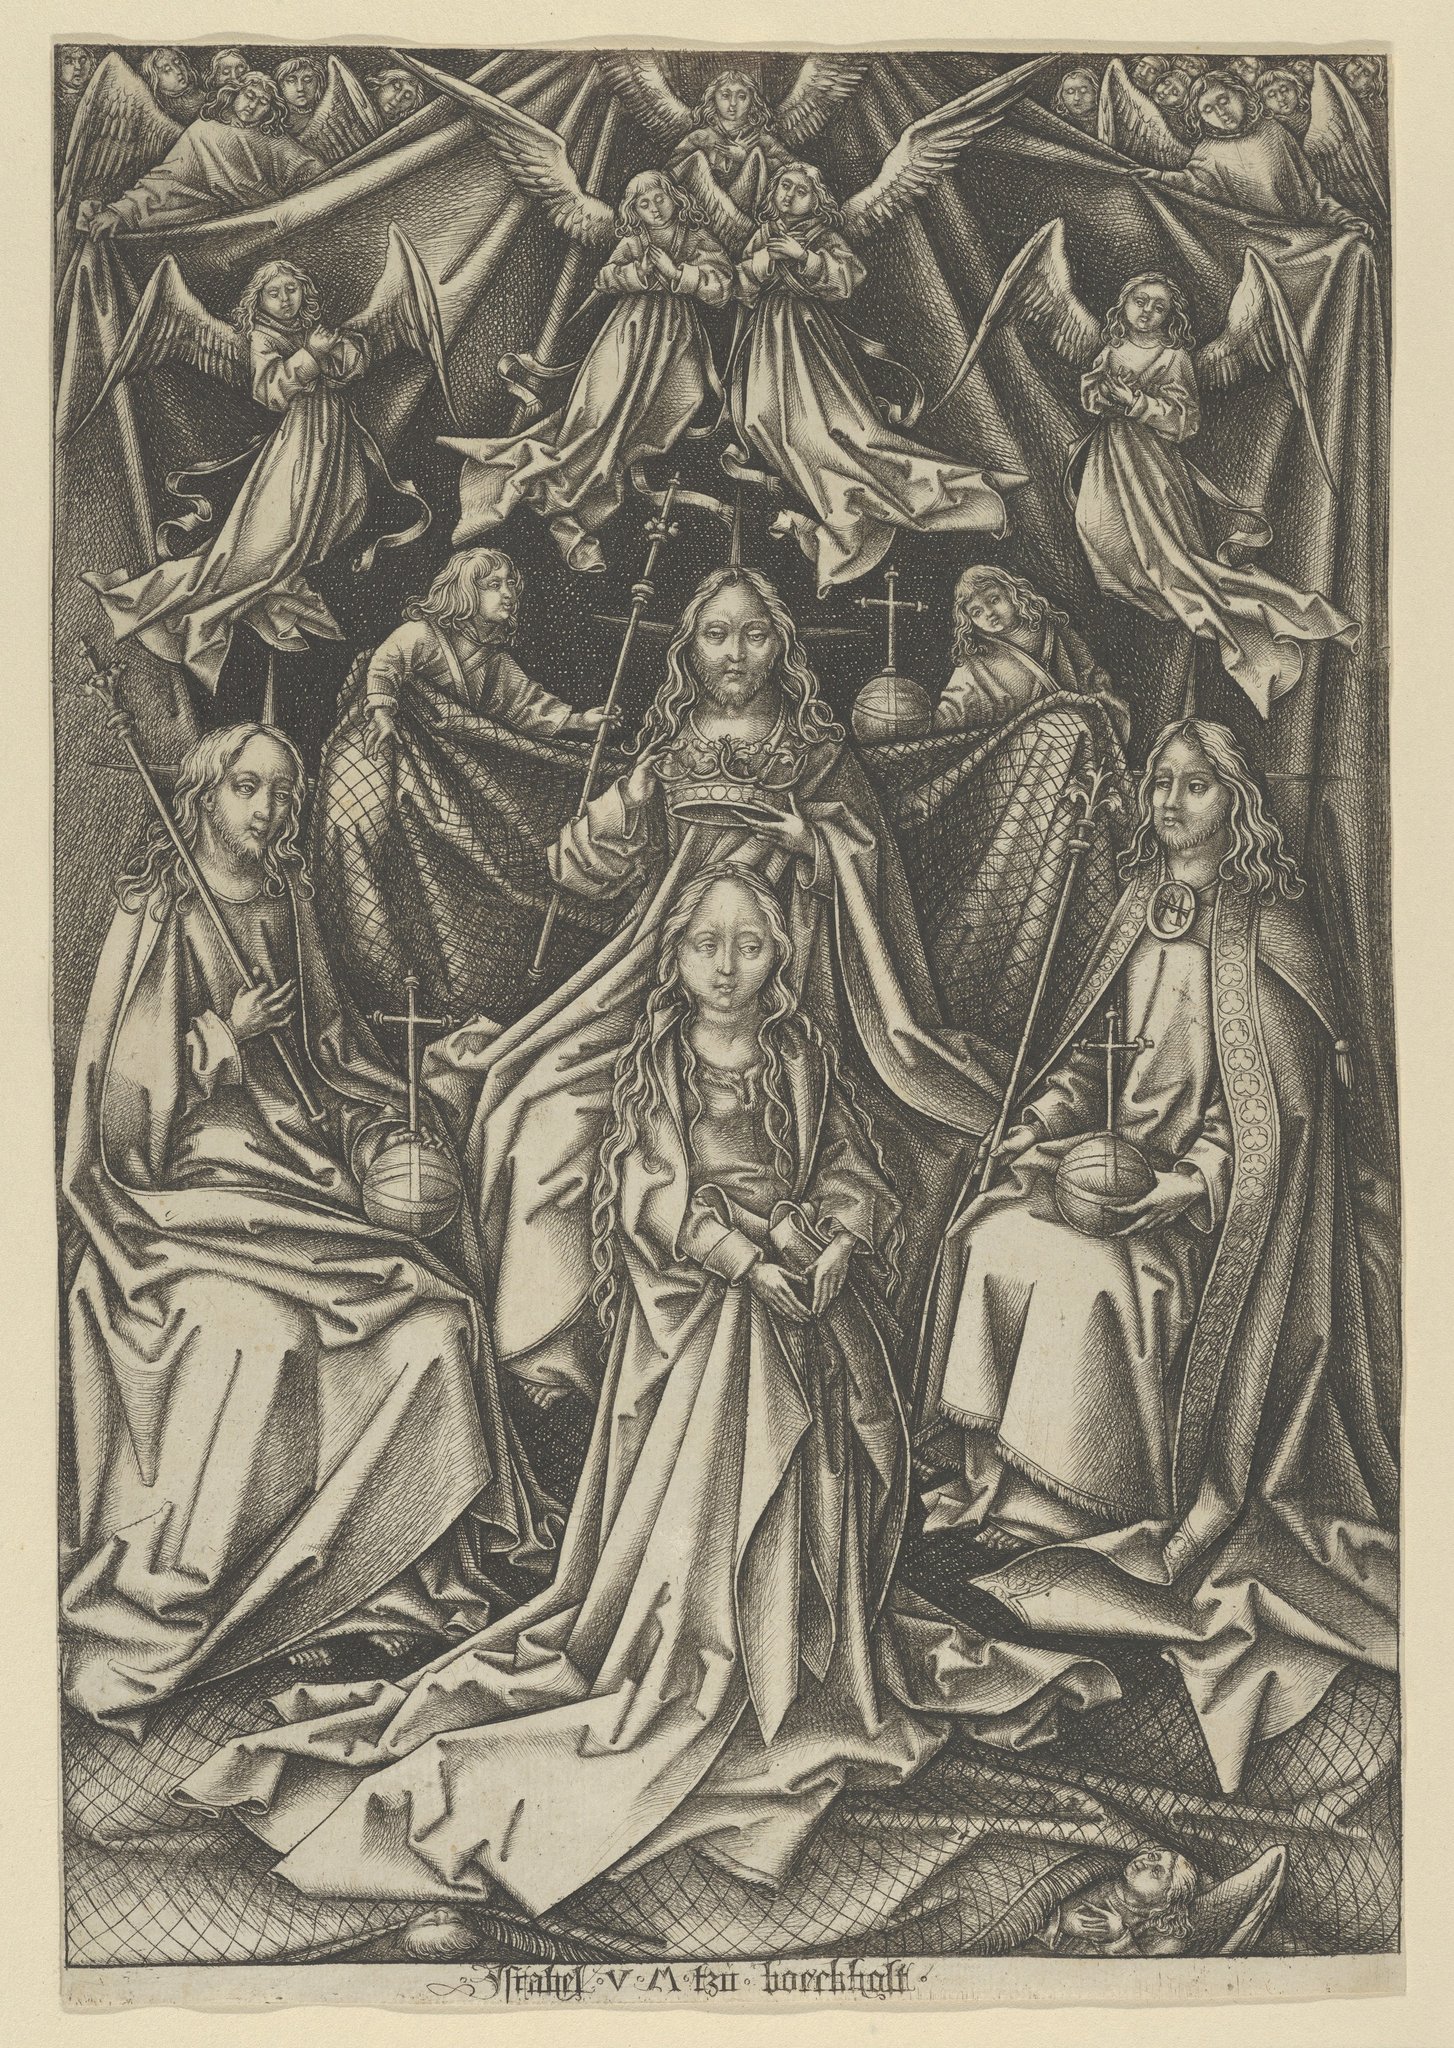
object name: print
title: The Coronation of the Virgin, from The Life of the Virgin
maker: israhel van meckenem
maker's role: artist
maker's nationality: german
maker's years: 1435-1503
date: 1435-1503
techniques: engraving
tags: angels,christ,virgin mary